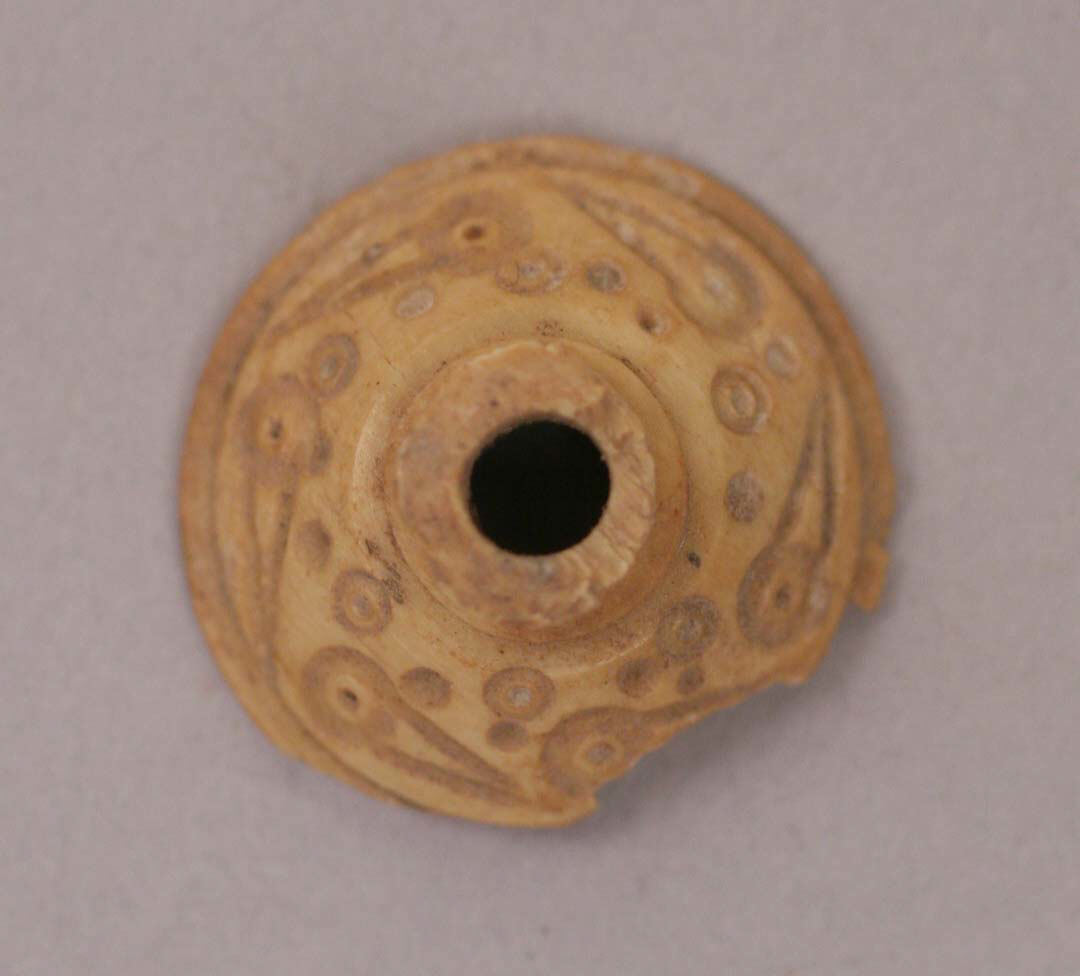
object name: button or bead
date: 801-1000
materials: bone, paint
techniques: incising, inlay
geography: iran